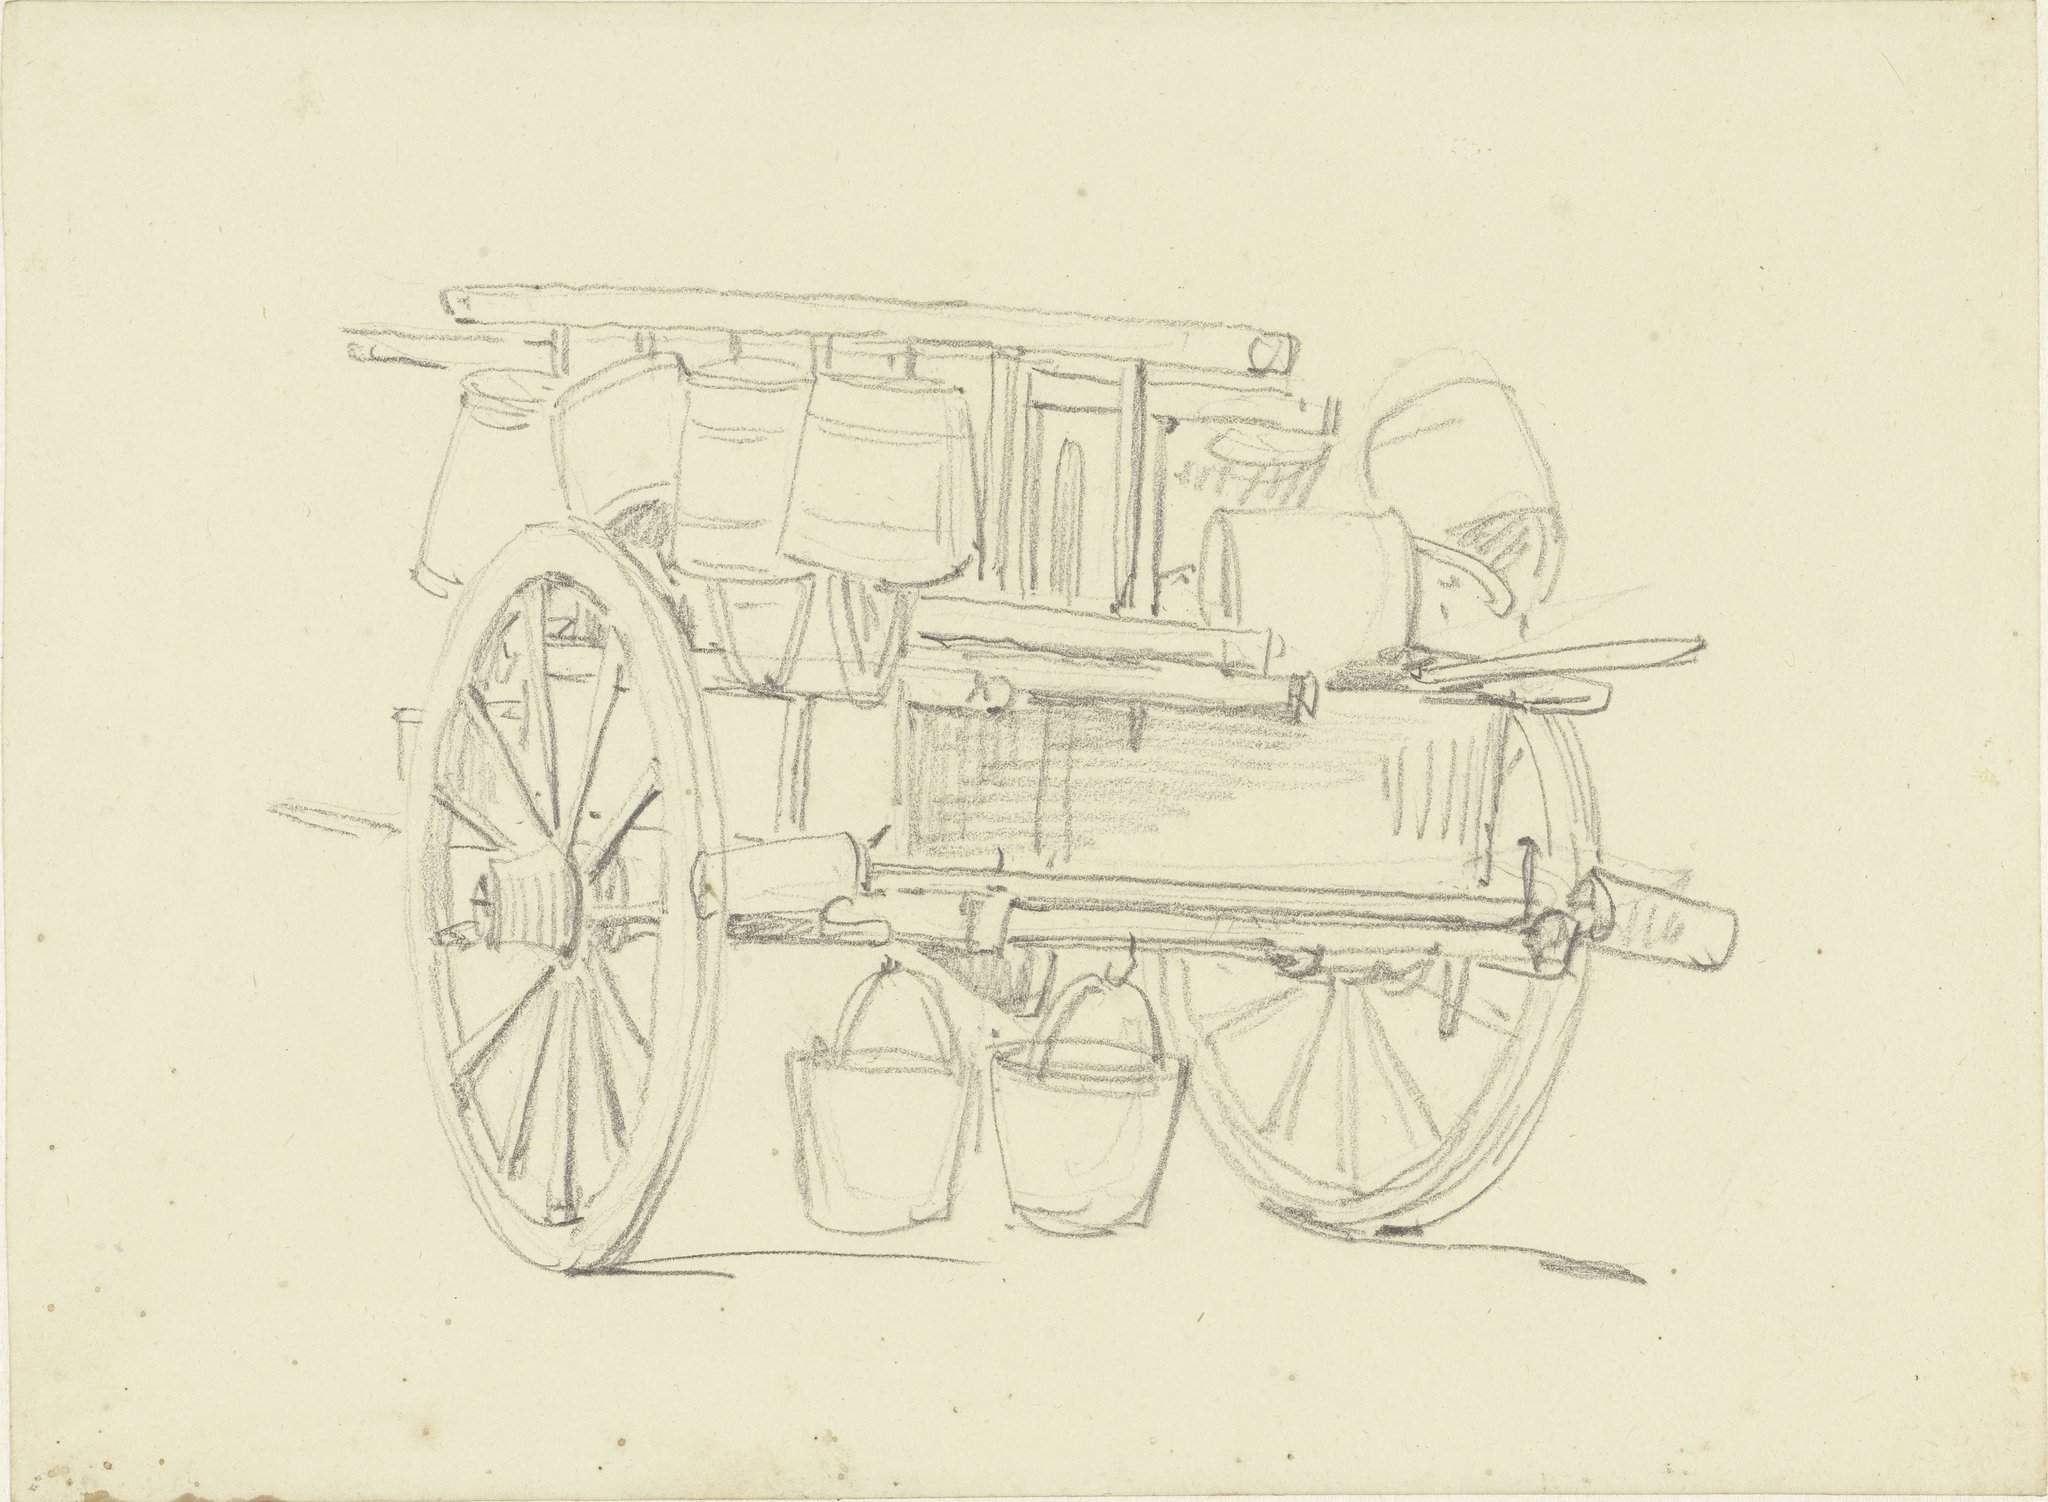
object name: drawing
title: Tweewielige kar met ladders en emmers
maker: hendrik voogd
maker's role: draughtsman, painter, print maker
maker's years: 1768-1839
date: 1788-1839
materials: paper, pencil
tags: two-wheeled, animal-drawn vehicle, pails (fire-extinguishing equipment), ladder